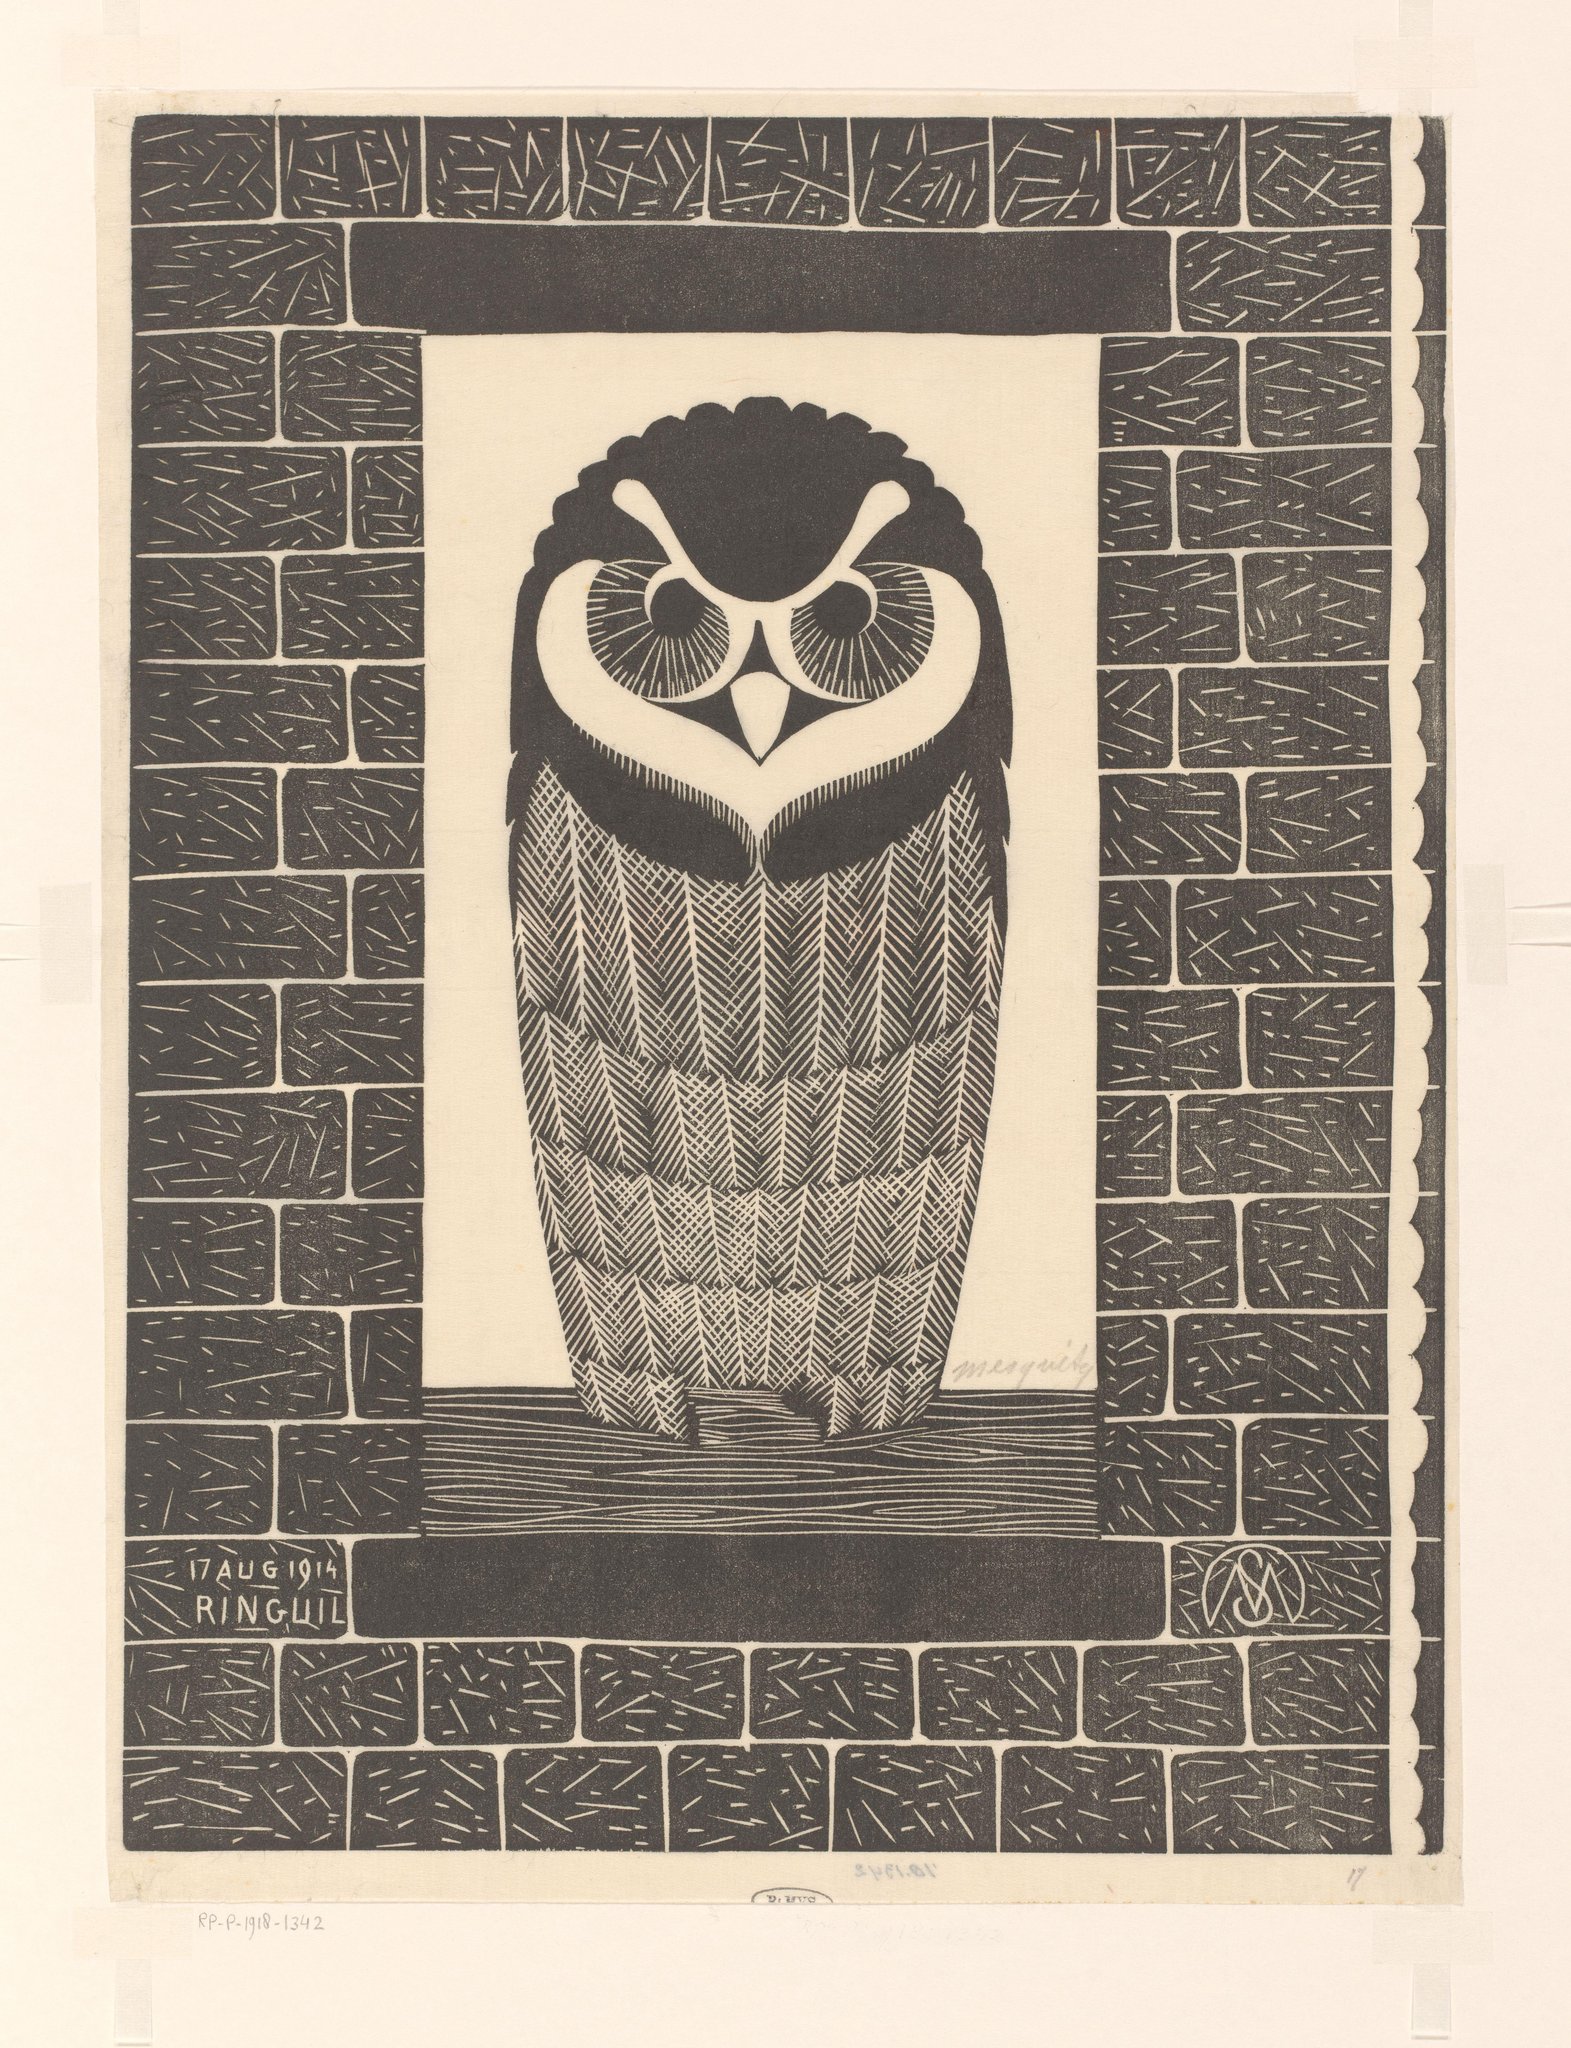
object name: print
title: Ringuil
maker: samuel jessurun de mesquita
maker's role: draughtsman, print maker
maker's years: 1868-1944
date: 1914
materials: paper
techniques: woodcut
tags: owls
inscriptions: number: ‘17’, collector's mark: Lugt 2228